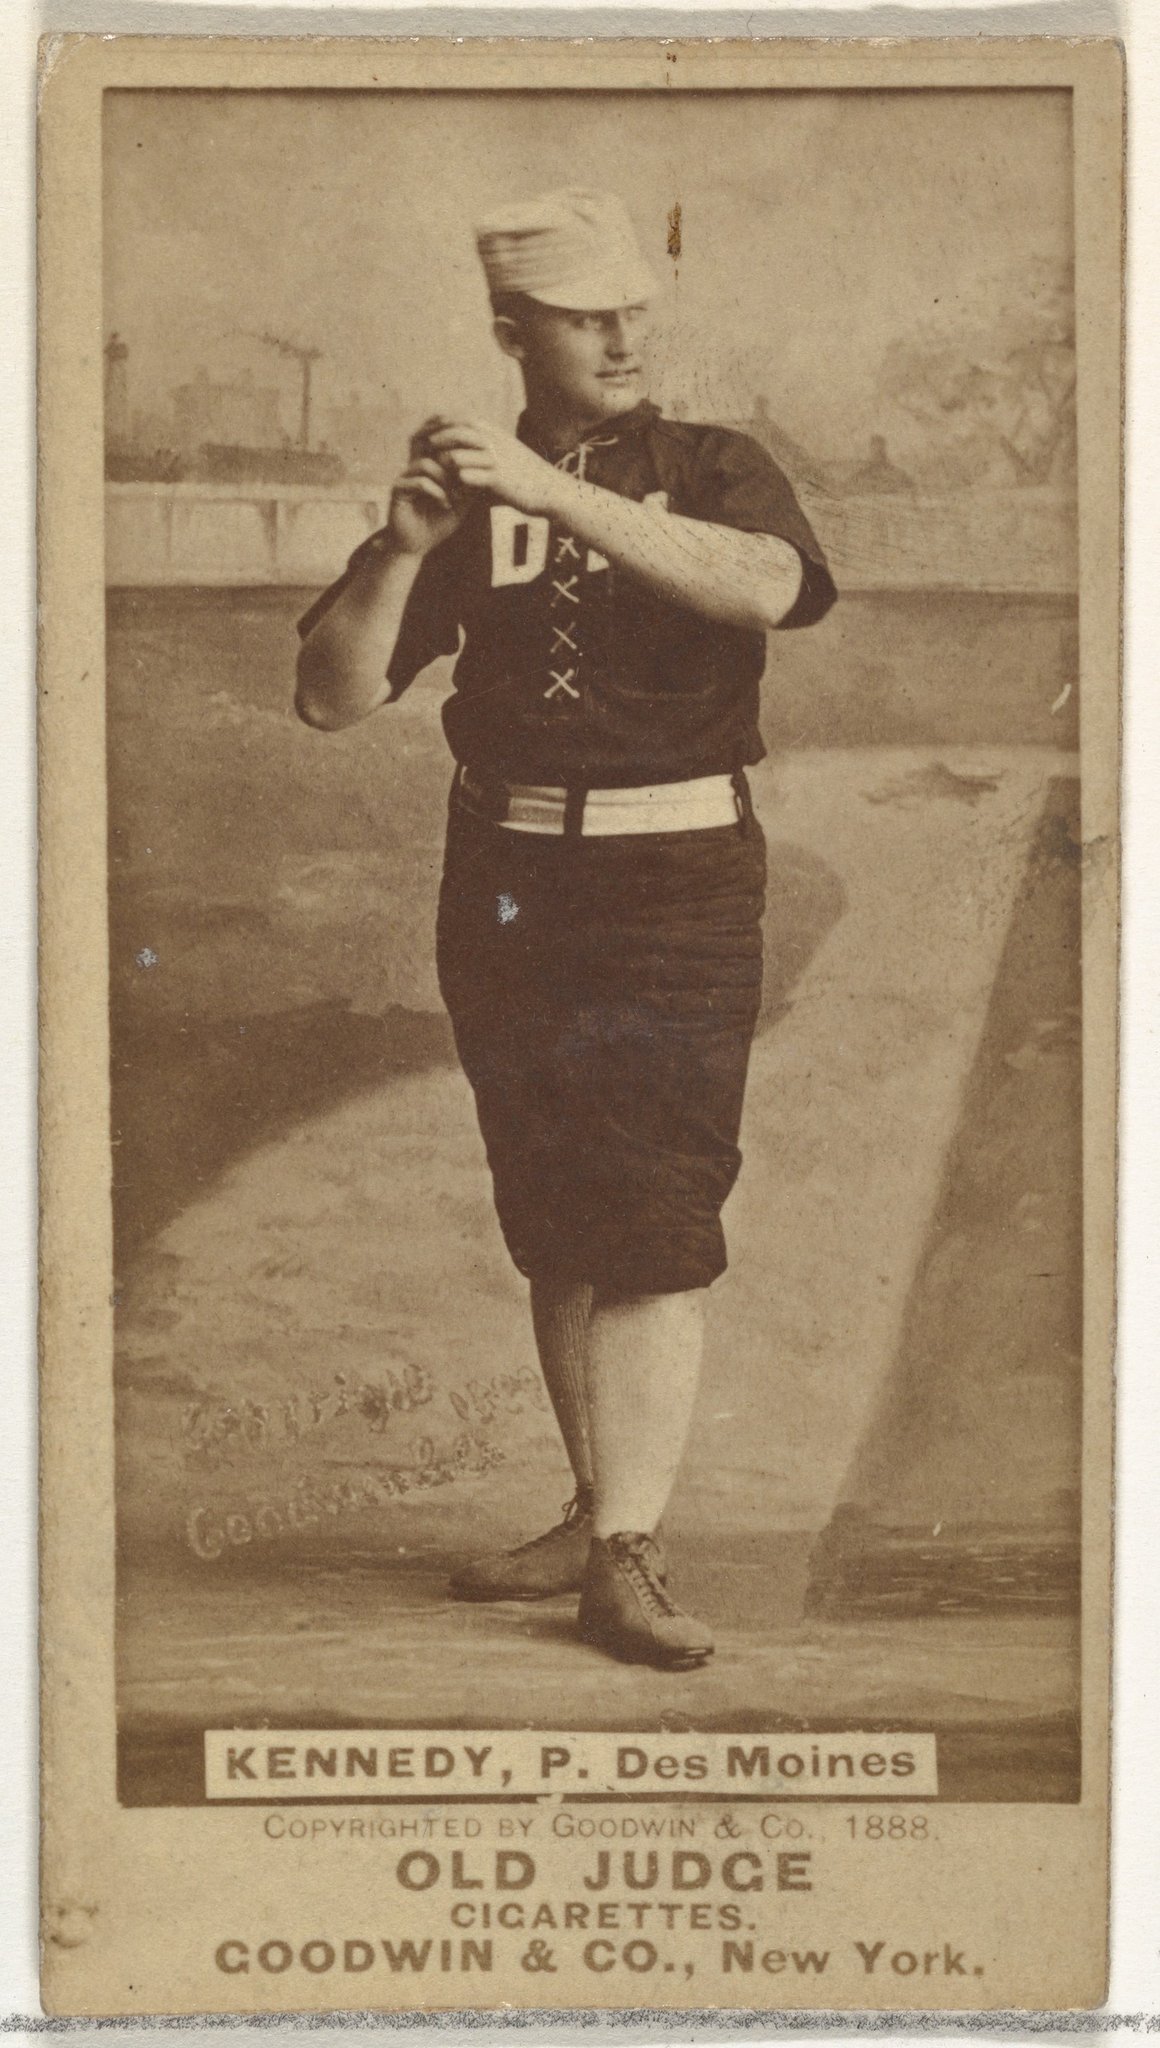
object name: baseball card, photograph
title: Theodore A. "Ted" Kennedy, Pitcher, Des Moines Prohibitionists, from the Old Judge series (N172) for Old Judge Cigarettes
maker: goodwin & company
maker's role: publisher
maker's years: 1850-1950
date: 1888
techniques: albumen silver print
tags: men,portraits,baseball,athletes